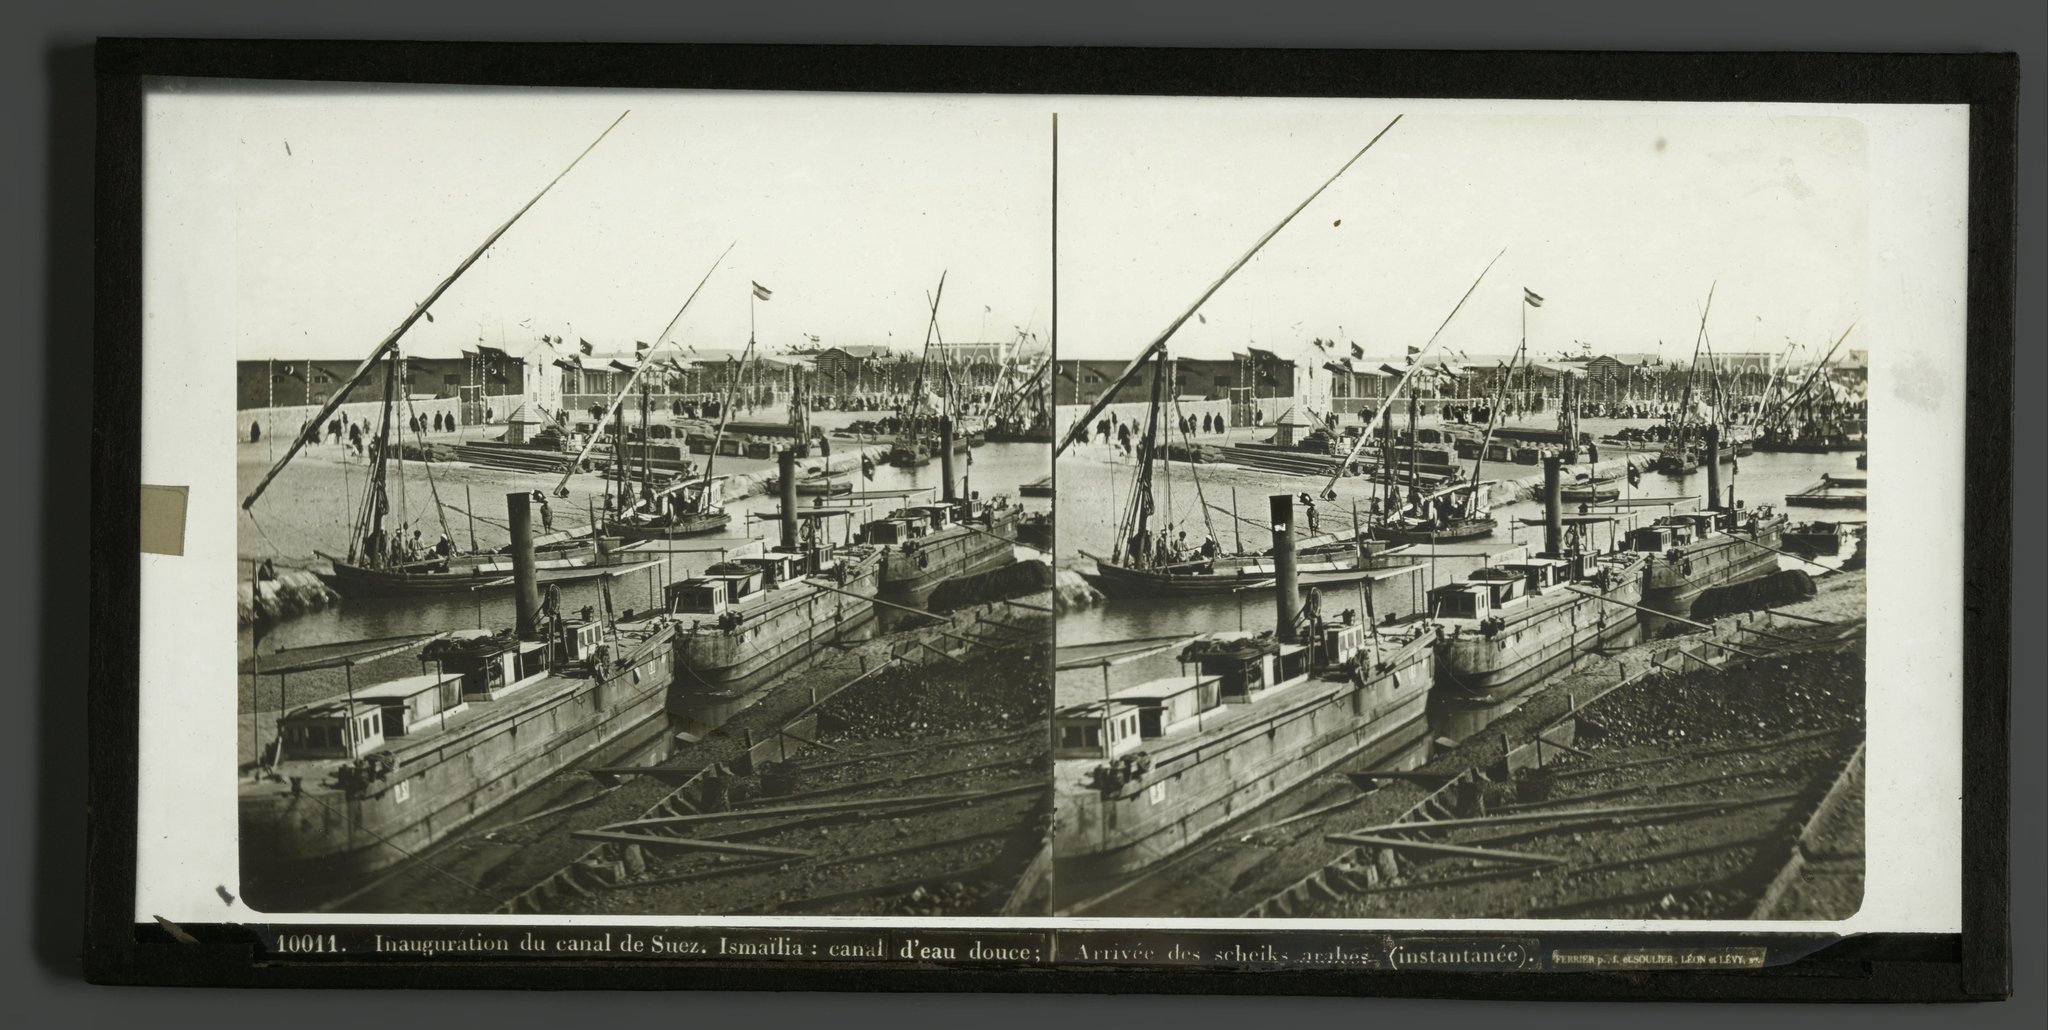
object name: stereoscopic photograph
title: Aankomst van de Arabische sjeiks voor de opening van het Suezkanaal, Egypte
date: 1869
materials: glass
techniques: slide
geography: suez canal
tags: canal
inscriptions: number: ‘10011’